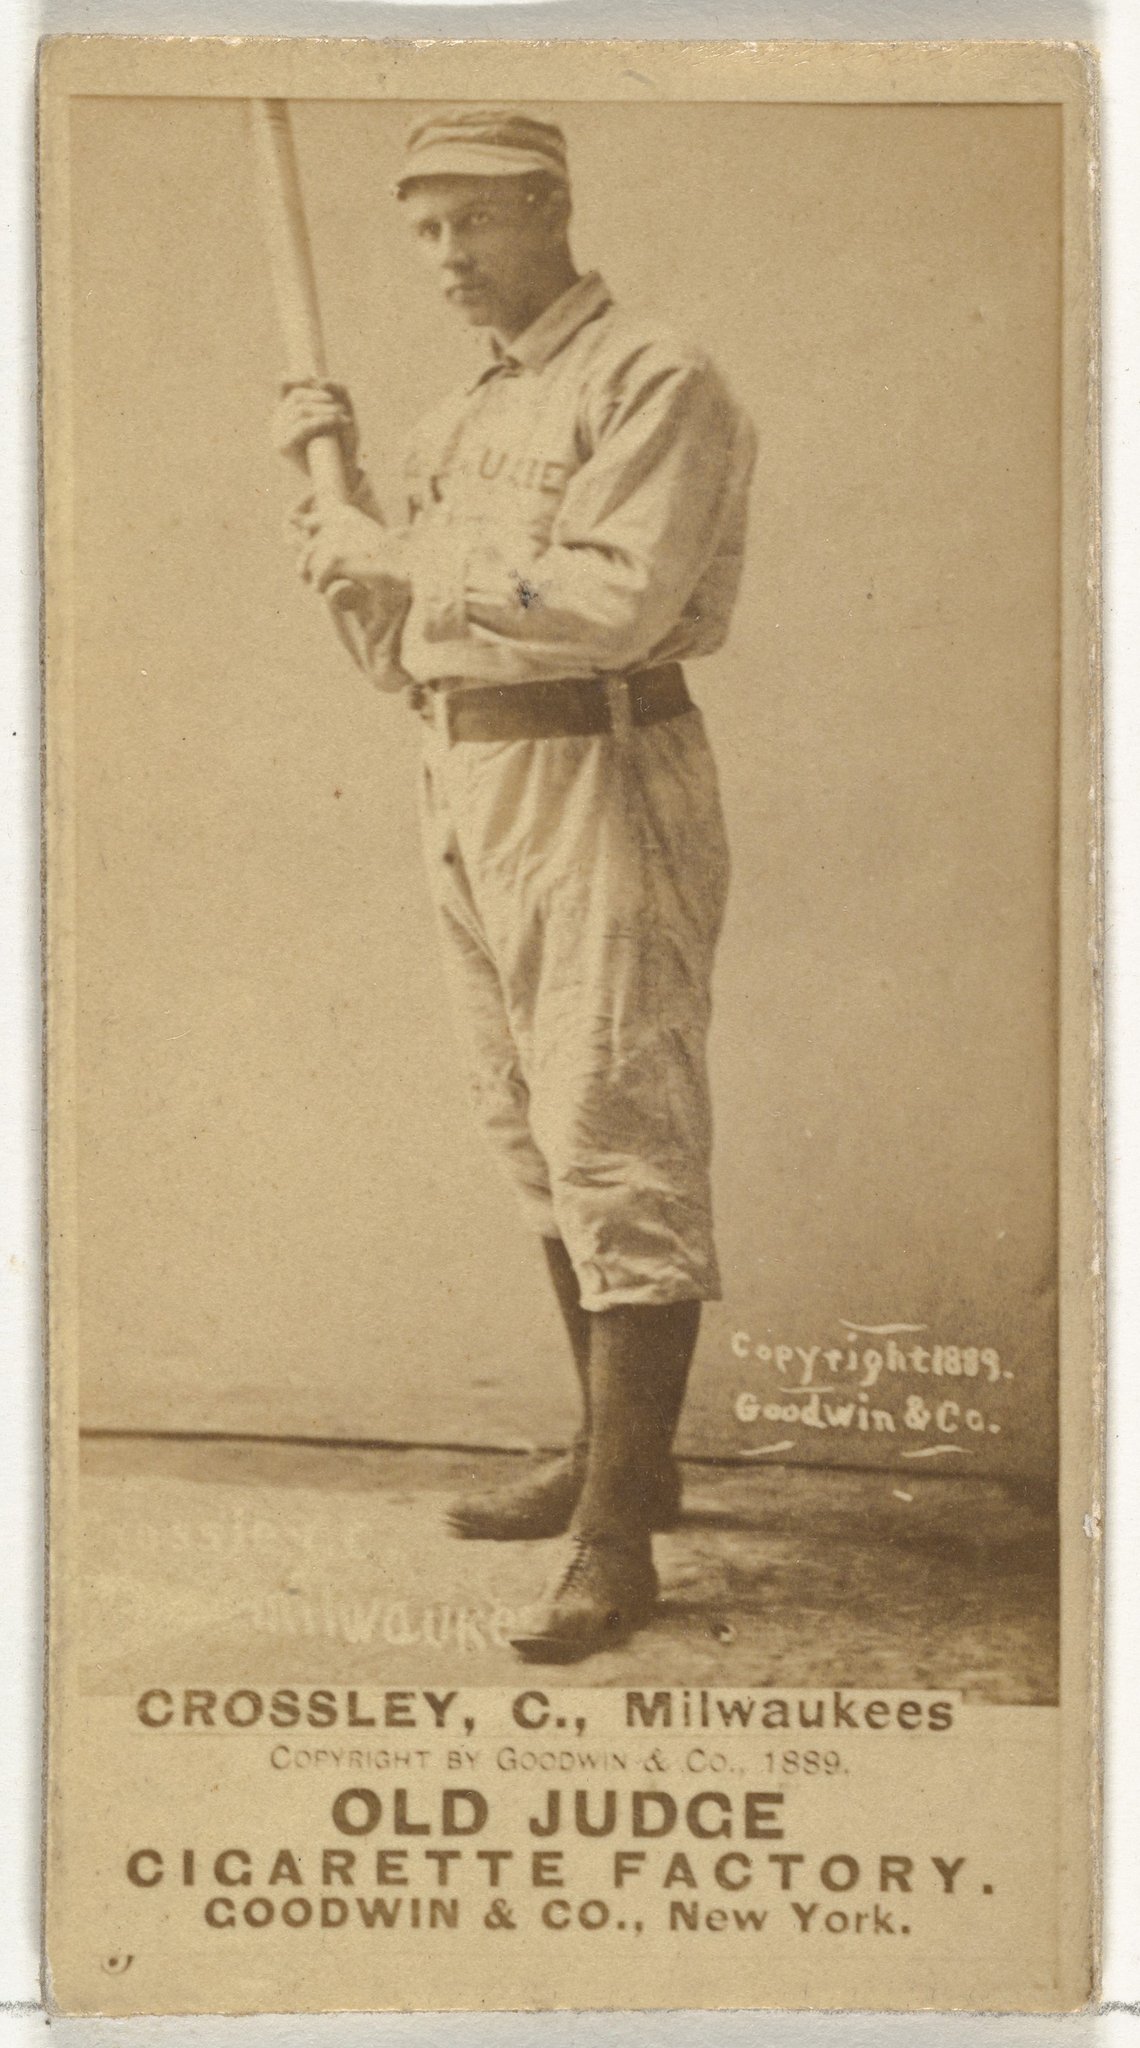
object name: baseball card, photograph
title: William C. Crossley, Catcher, Milwaukee, from the Old Judge series (N172) for Old Judge Cigarettes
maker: goodwin & company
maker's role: publisher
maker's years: 1850-1950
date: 1889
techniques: albumen silver print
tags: men,portraits,baseball,athletes